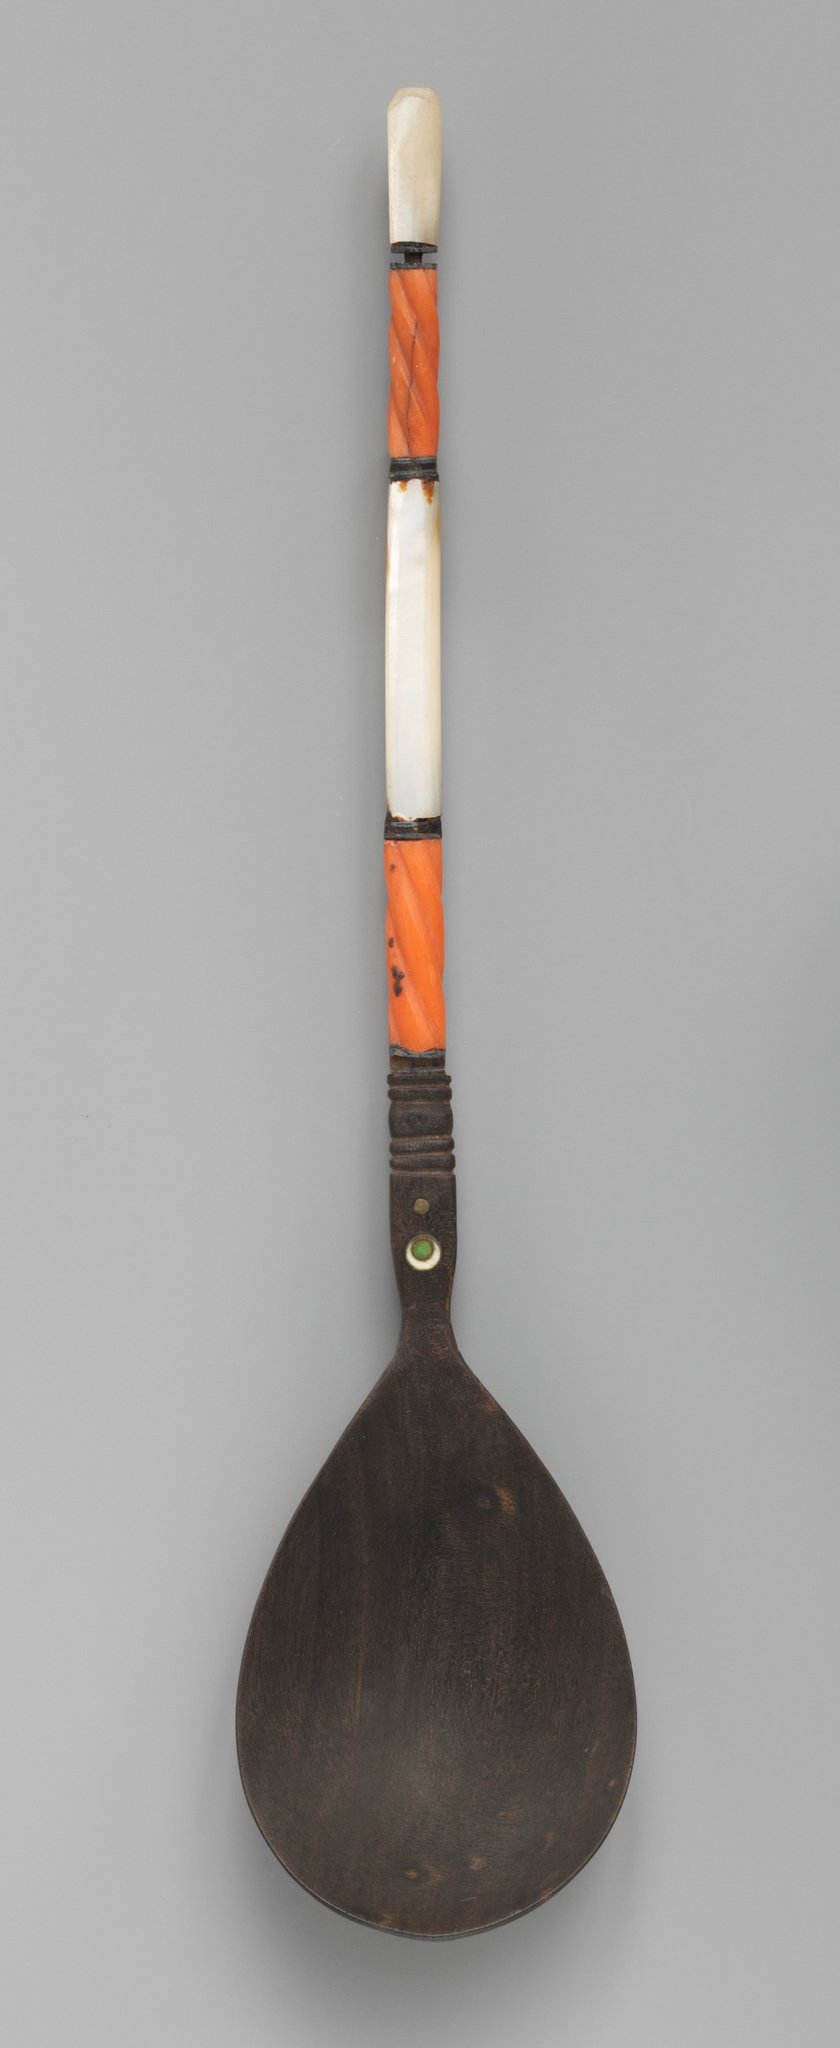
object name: spoon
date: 1701-1800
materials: brass, coral, mother of pearl, wax, wood